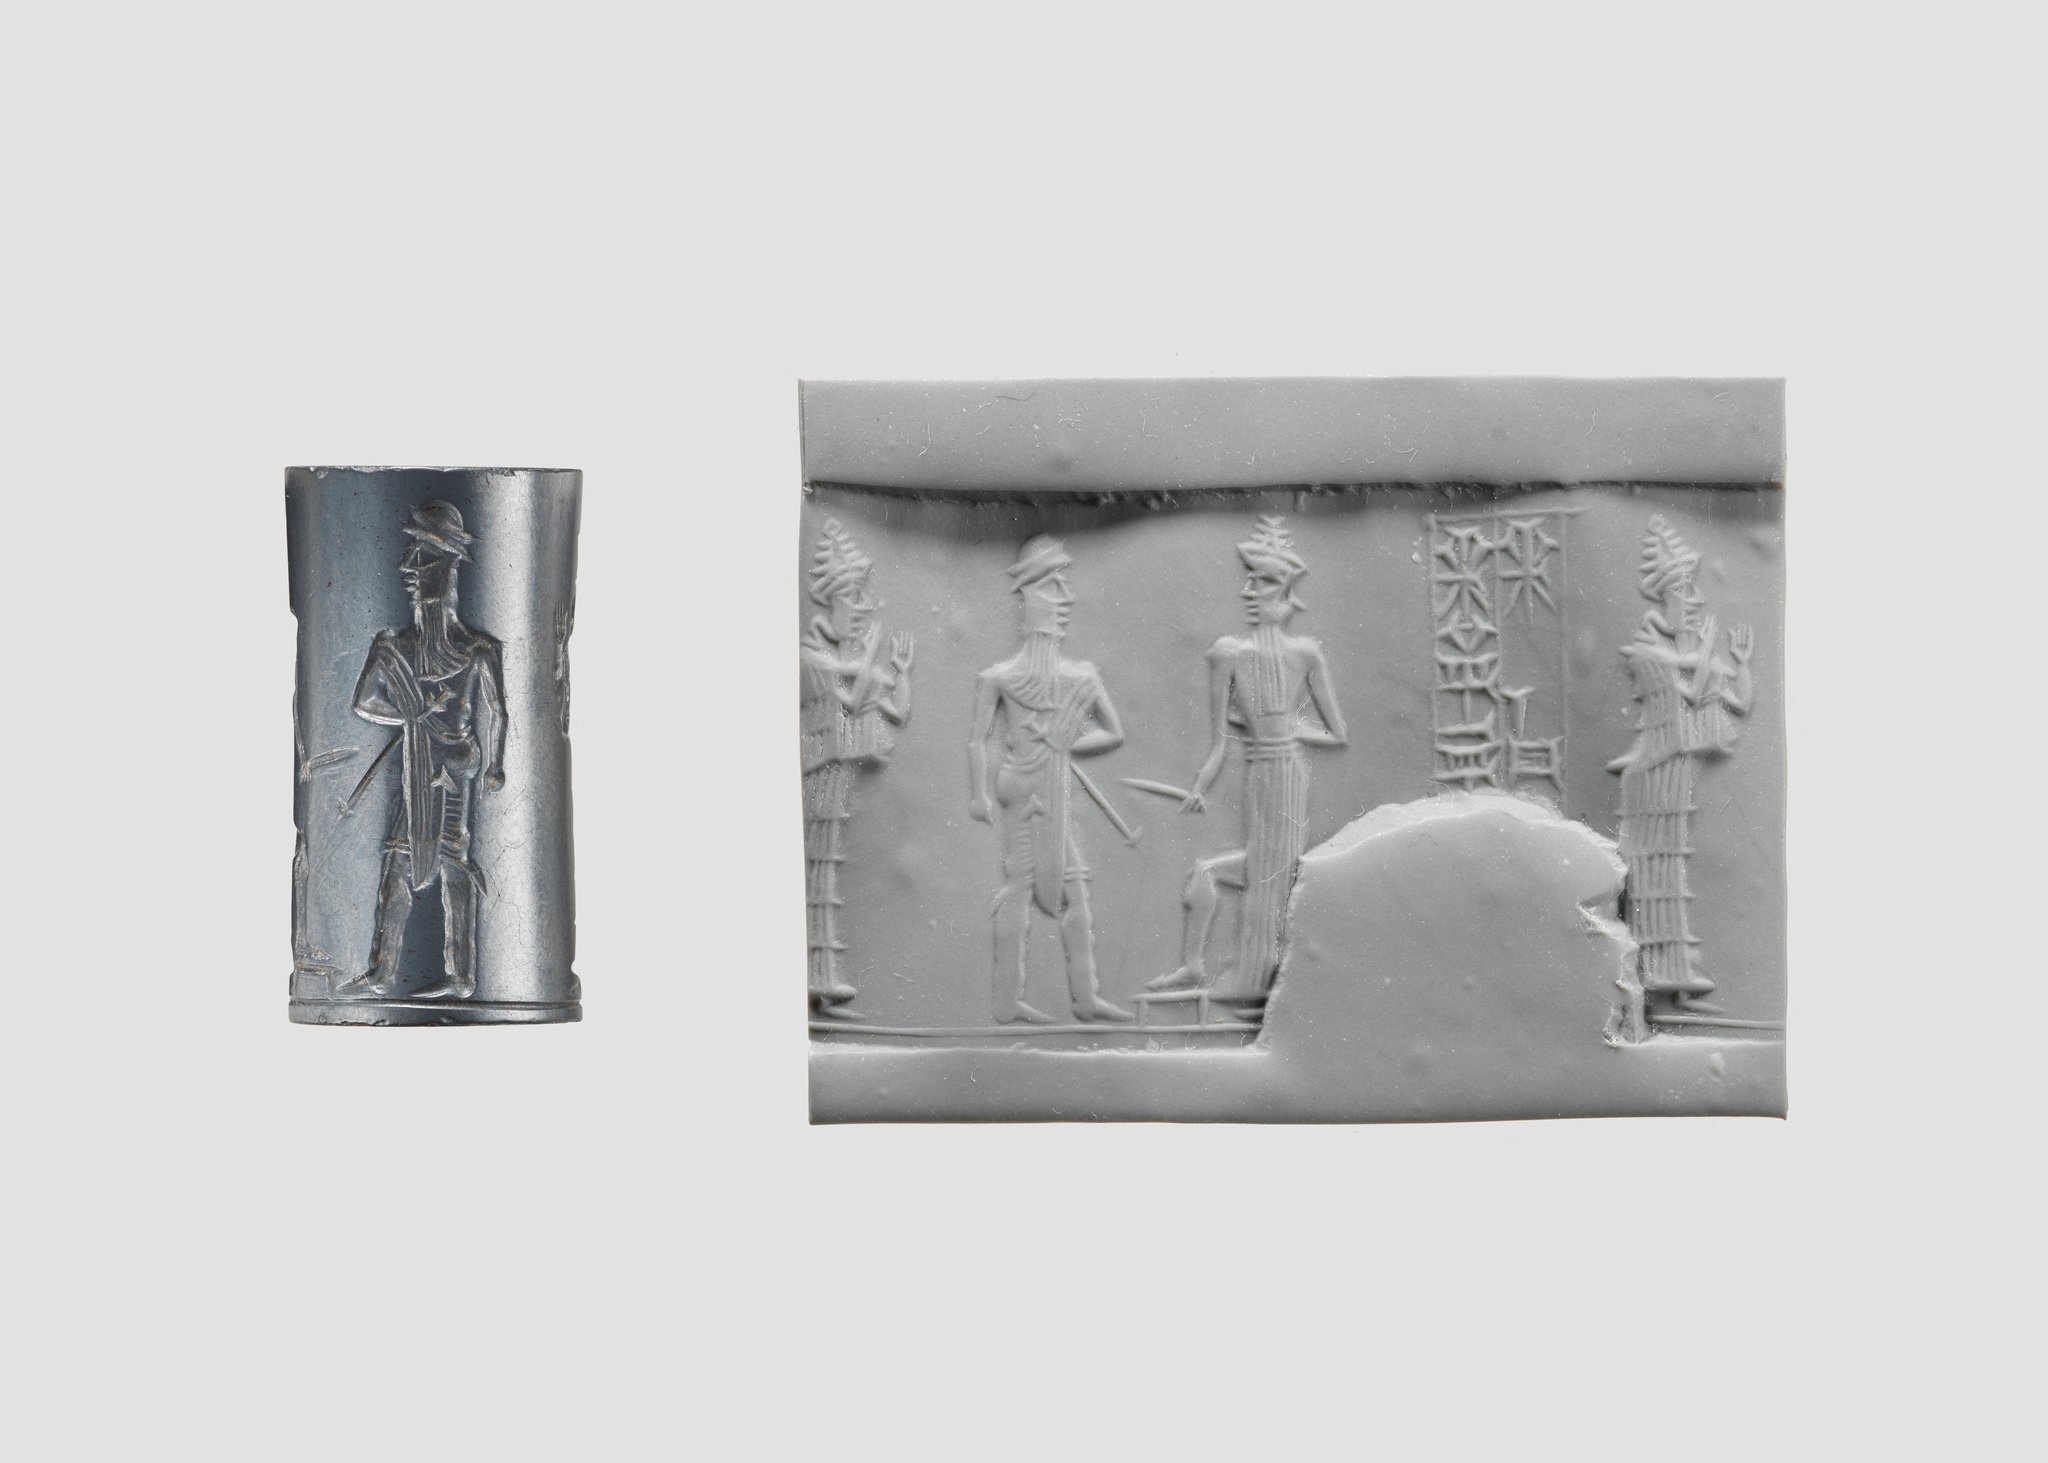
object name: cylinder seal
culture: babylonian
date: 2000-1668 BCE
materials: mineral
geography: mesopotamia